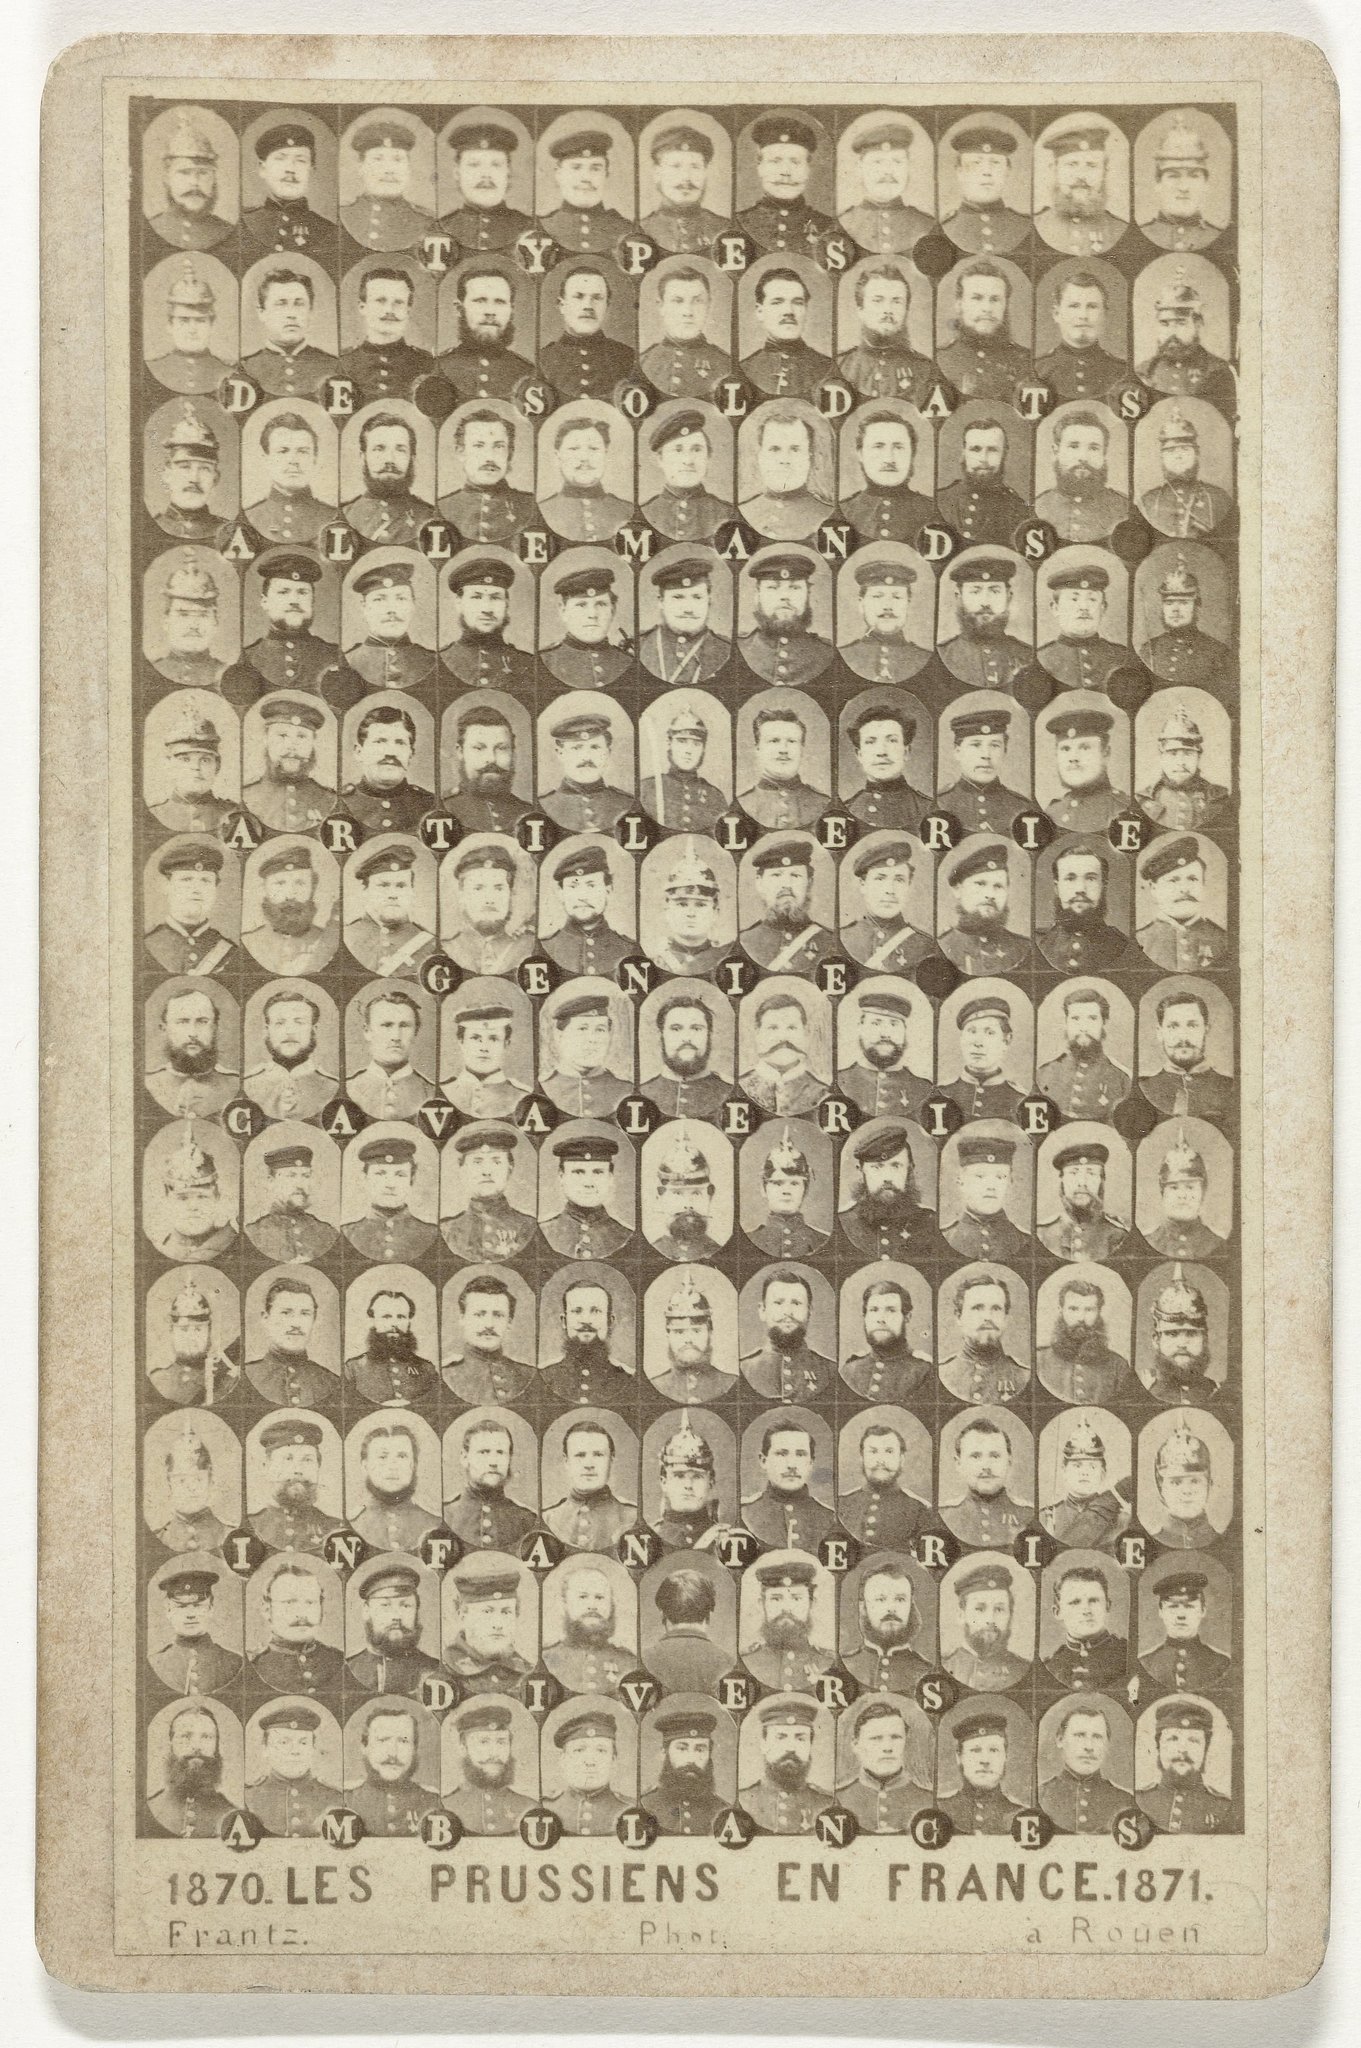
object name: photograph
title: Soldiers and Officers in the Franco-Prussian War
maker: frantz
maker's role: fotograaf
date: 1870-1871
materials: paper, photographic support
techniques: albumen print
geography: france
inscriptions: annotation: ‘TYPES / DE SOLDATS / ALLEMANDS / ARTILLERIE / GENIE / CABALERIE / INFANTERIE / DIVERS / AMBULANCES / 1870. LES PRISSIENS EN FRANCE.1871. / Frantz. / Phot. / a Rouen’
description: France and Germany went to war in 1870. After a swift victory, Germany occupied a part of France. Rouen, where the maker of these photographs lived, lay in this area. Perhaps his fellow citizens used them to identify the foreign soldiers. In any case, they were small enough to fit into a coat pocket and could be consulted inconspicuously.